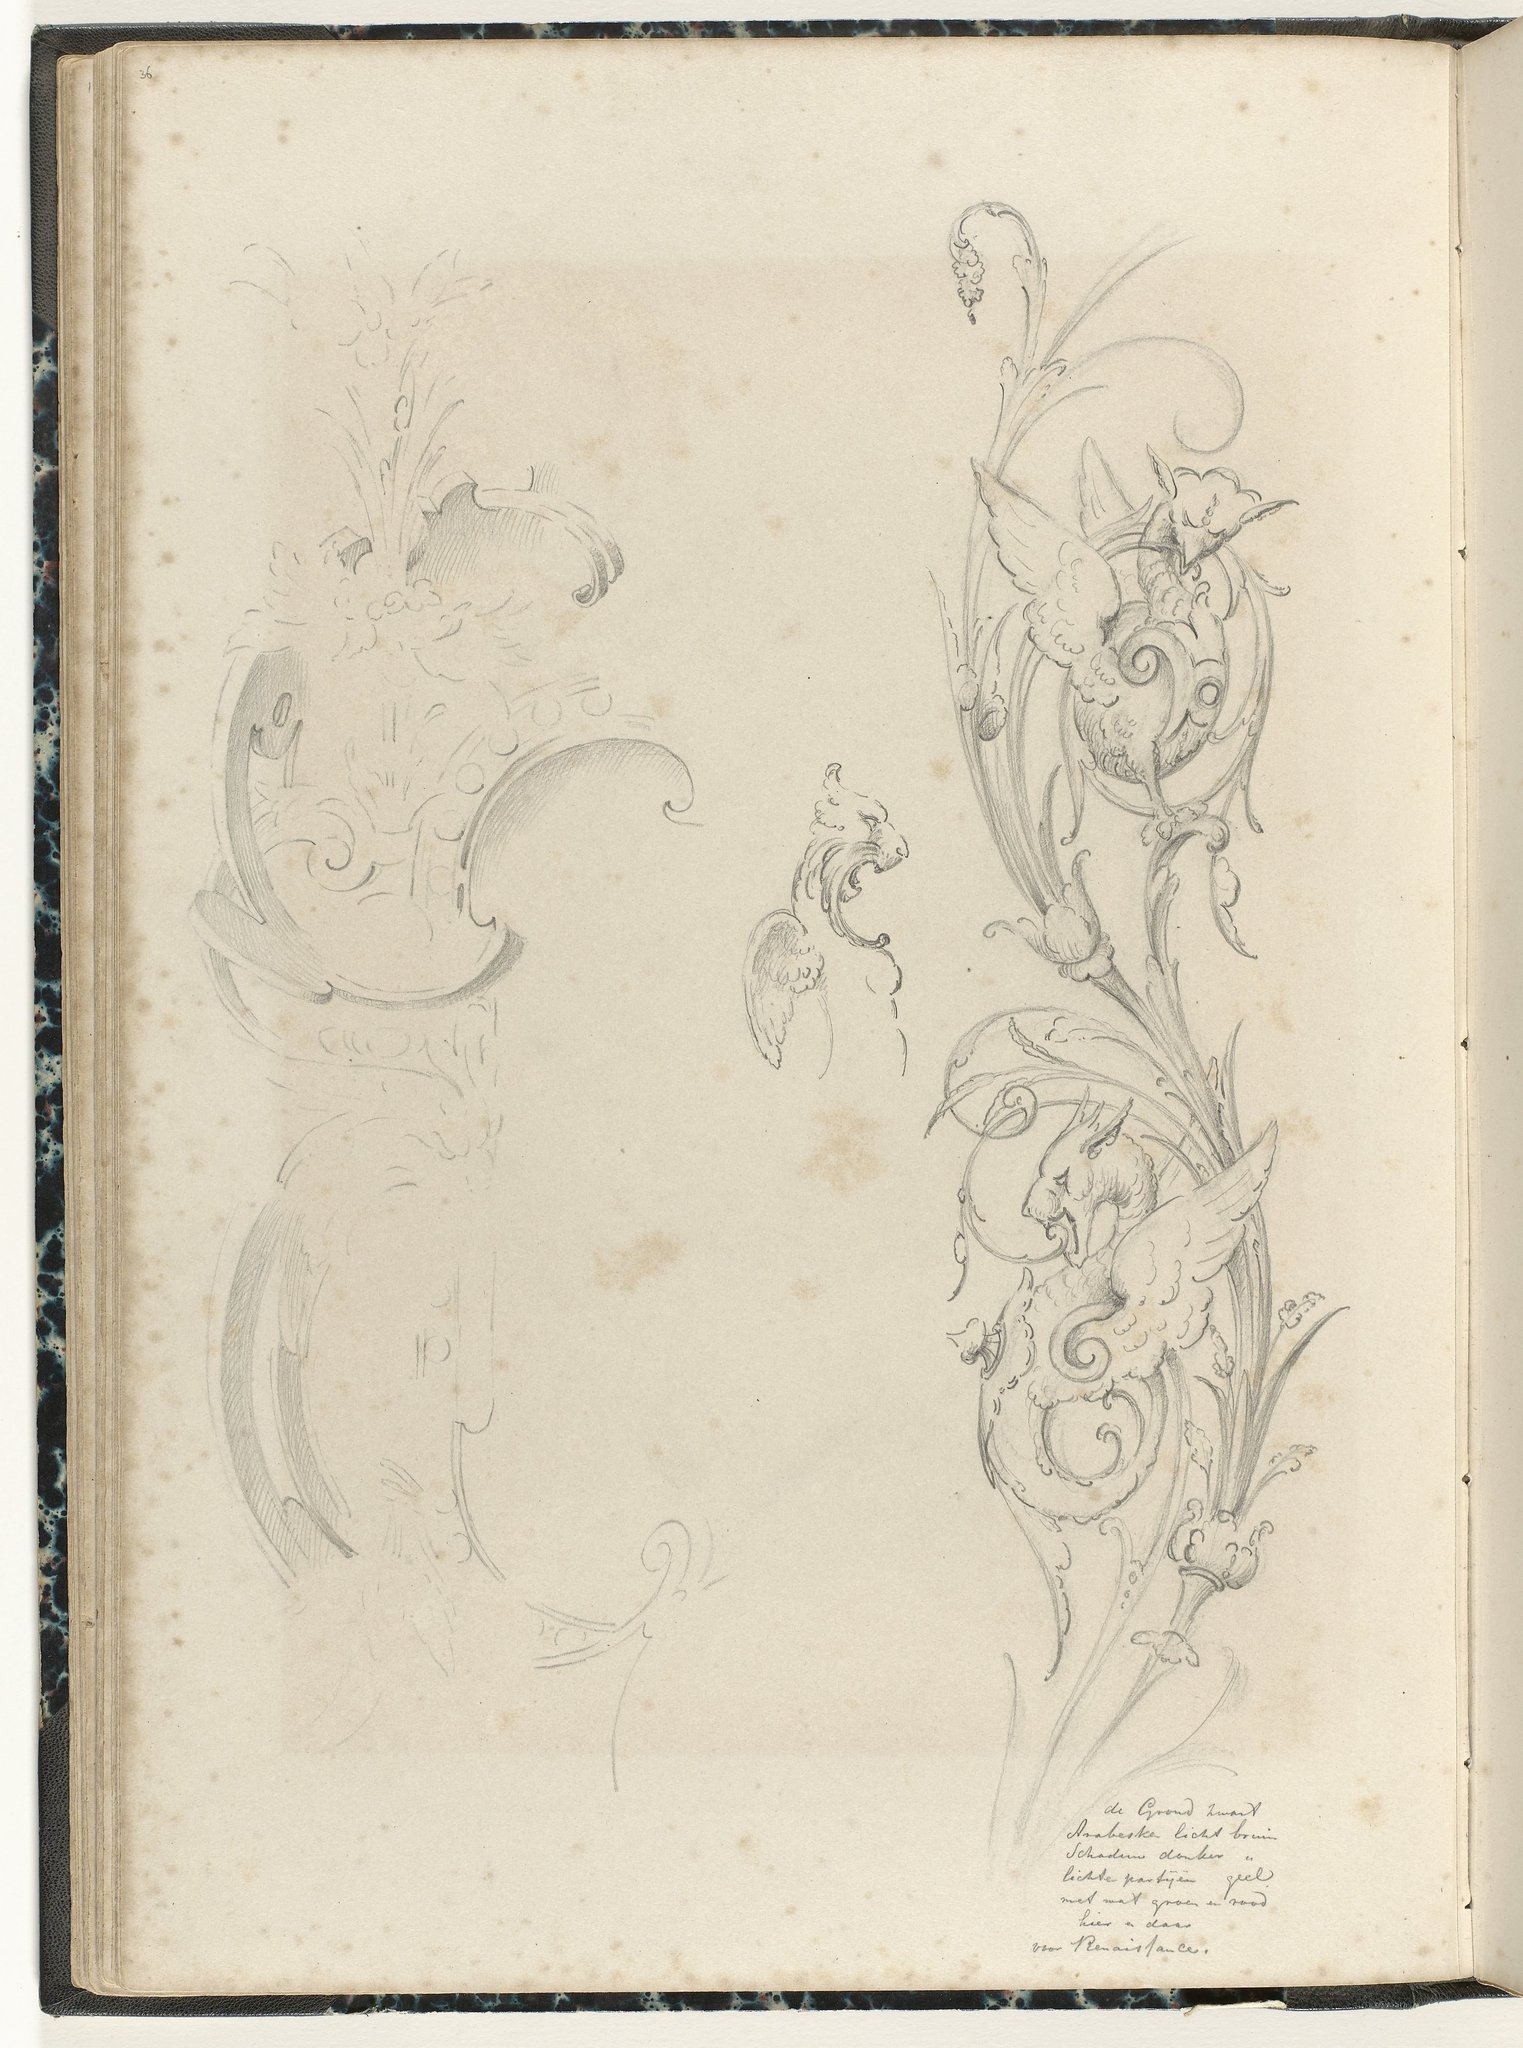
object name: drawing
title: Drie ornamenten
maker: Anonymous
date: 1866-1900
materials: paper, pencil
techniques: drawing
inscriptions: annotation: ‘de Grond zwart / Arabesken licht bruin / Schaduw donker en / lichte partijen geel / met mat groen en rood / hier en daar / voor Renaissance.’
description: Rechts een bladrank waarbij twee voluten uitlopen in fantasiedieren.